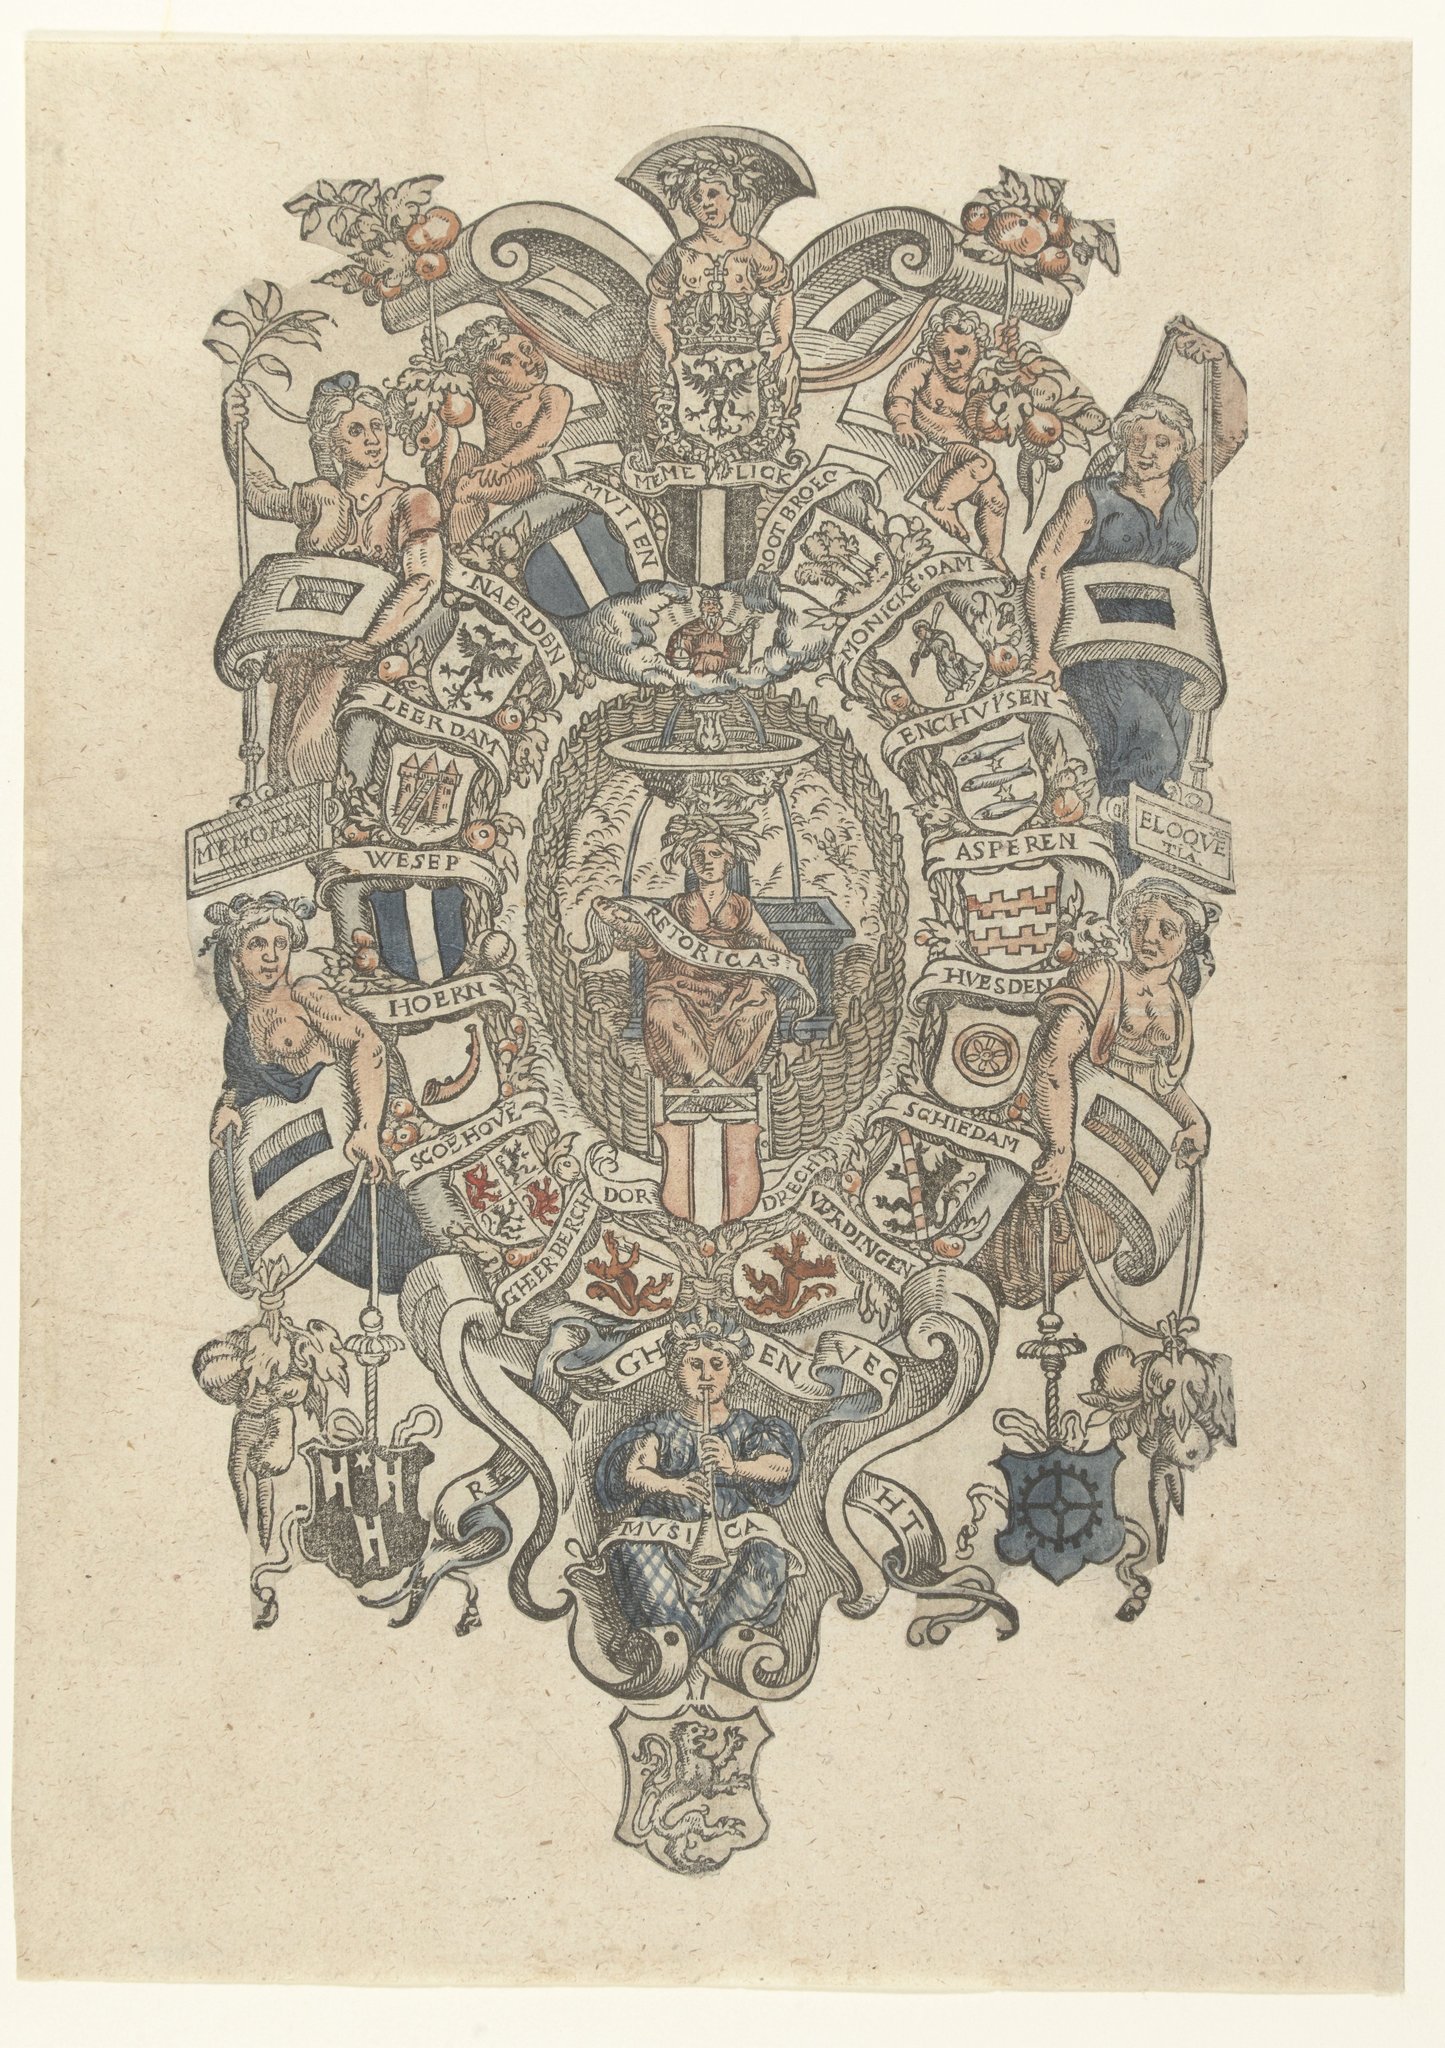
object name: print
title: Ontwerp voor het blazoen voor de Dordtse rederijkerskamer De Fonteynisten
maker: Anonymous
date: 1547-1557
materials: paper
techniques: hand coloring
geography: low countries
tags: 'rhetorica', 'eloquentia' (~ trivium); 'rettorica' (ripa), 'musica' (~ quadrivium); 'musica' (ripa), chamber of rhetoric (dutch: 'rederijkerskamer'), memory; 'memoria' (ripa), dordrecht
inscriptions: collector's mark: Lugt 2228a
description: Ontwerp voor het blazoen voor de Dordtse rederijkerskamer De Fonteynisten, met als devies: Reyn Gheneucht. Waarschijnlijk het ontwerp voor de "Caerte" uitgeschreven in 1552 te Dordrecht voor de rederijkerskamer De Fonteynisten. Personificatie Retorica zittend in de Hollandse tuin met het wapen van Dordrecht op het hek. Hieromheen de wapens en namen van de 15 steden die vroeger onder Dordrecht ten strijde trokken. Links in het randwerk Memoria, rechts Eloquentia en onderaan Musica. De voorstelling uitgeknipt en opgeplakt. Linksonder het wapen van Dirck van Nuyssenborch, in 1550 overman der Fonteynisten.